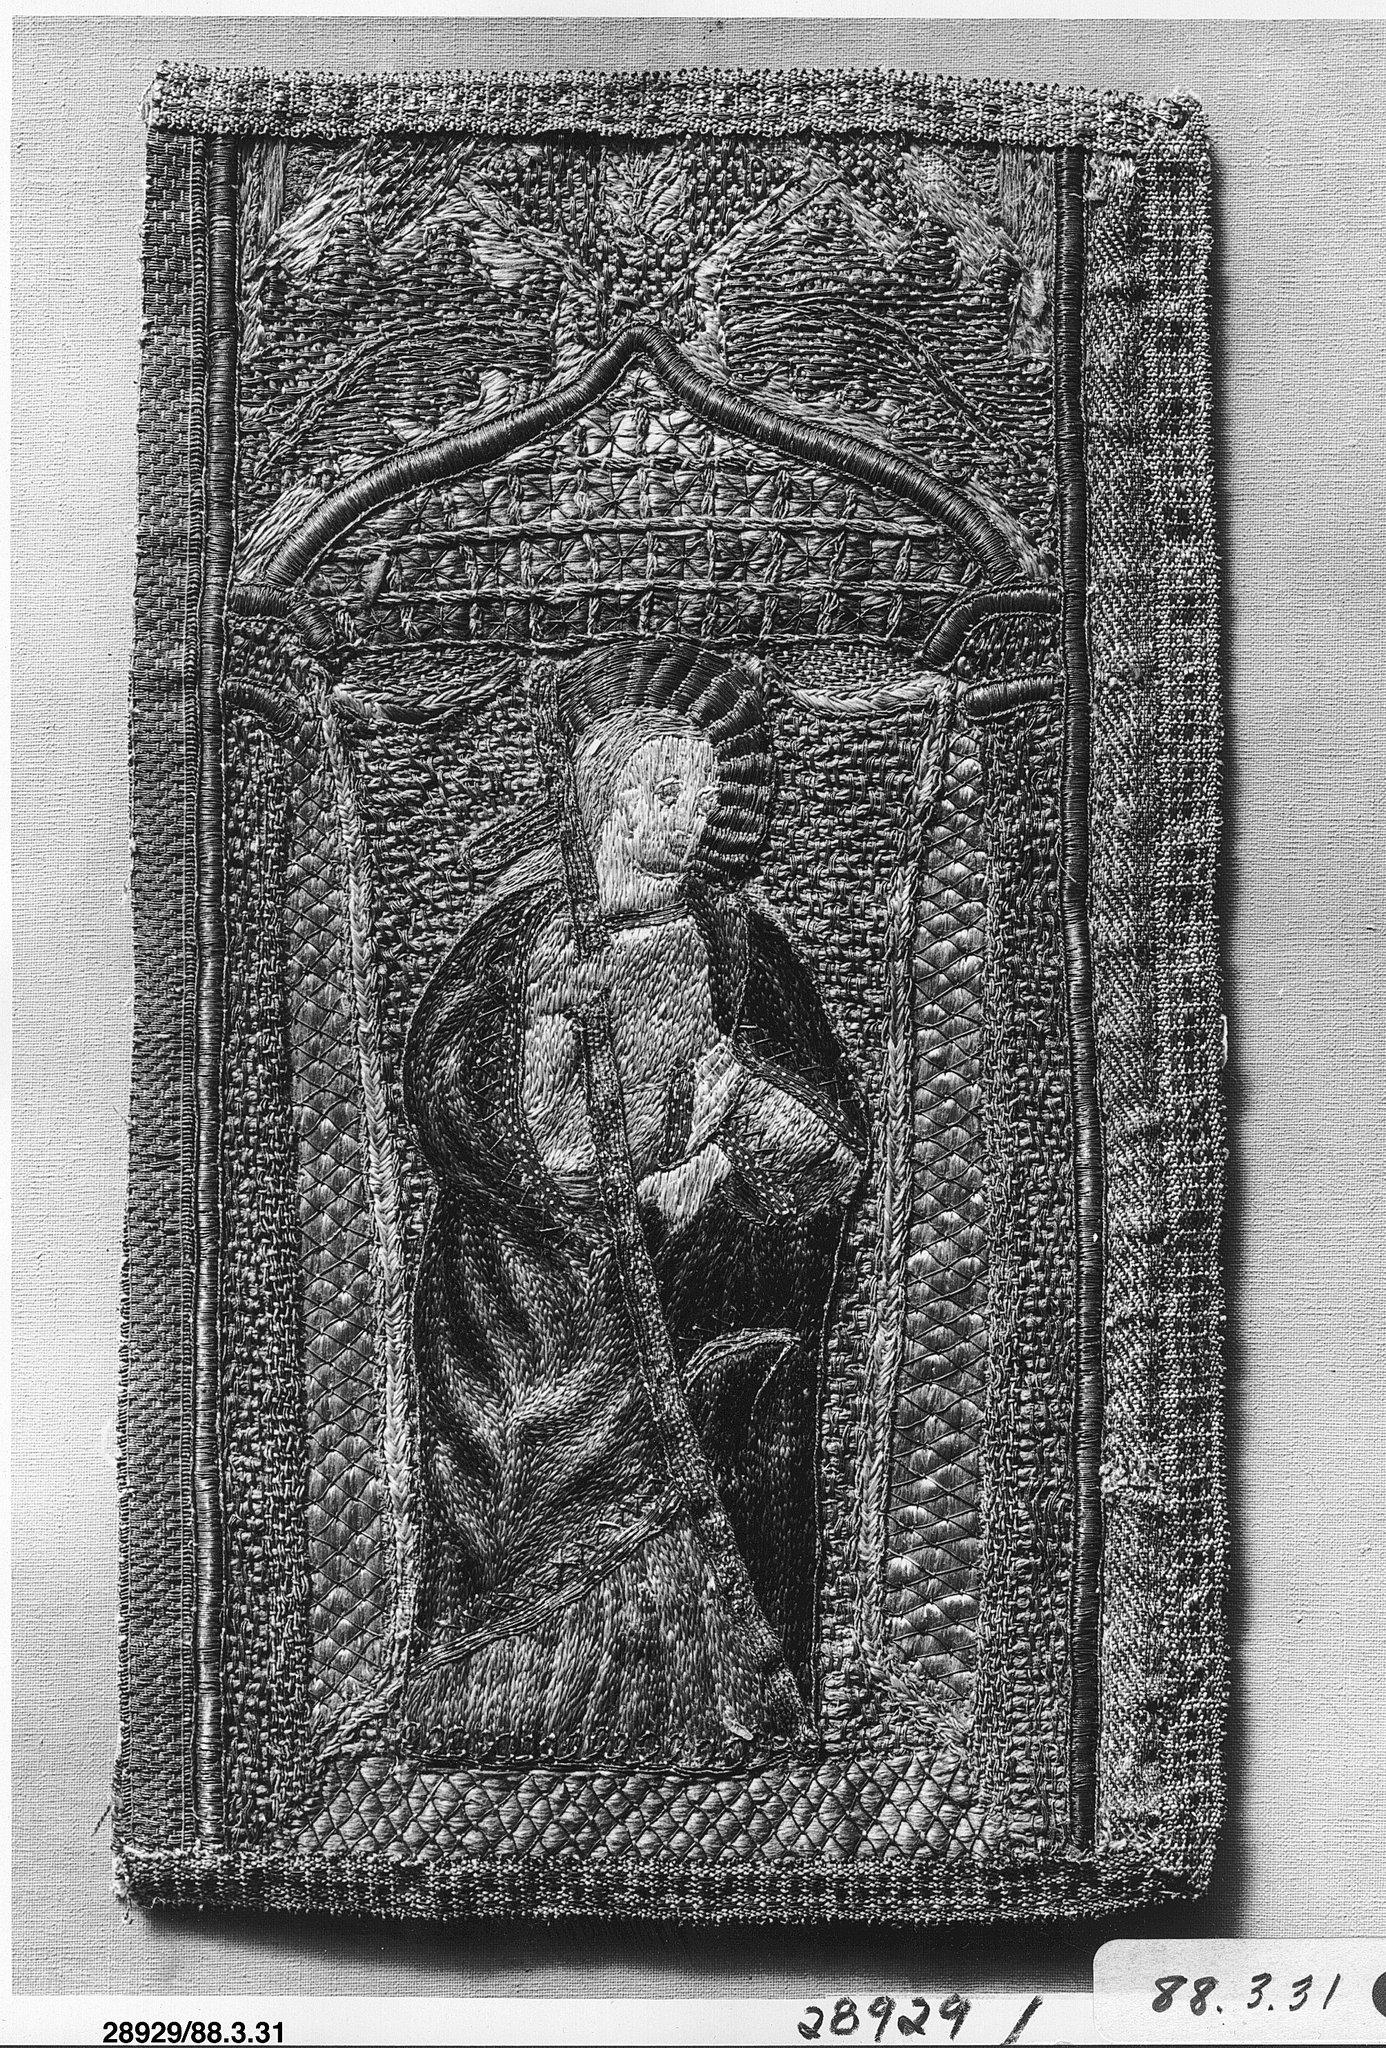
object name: panel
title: Female saint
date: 1401-1500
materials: canvas, metal thread, silk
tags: women,saints